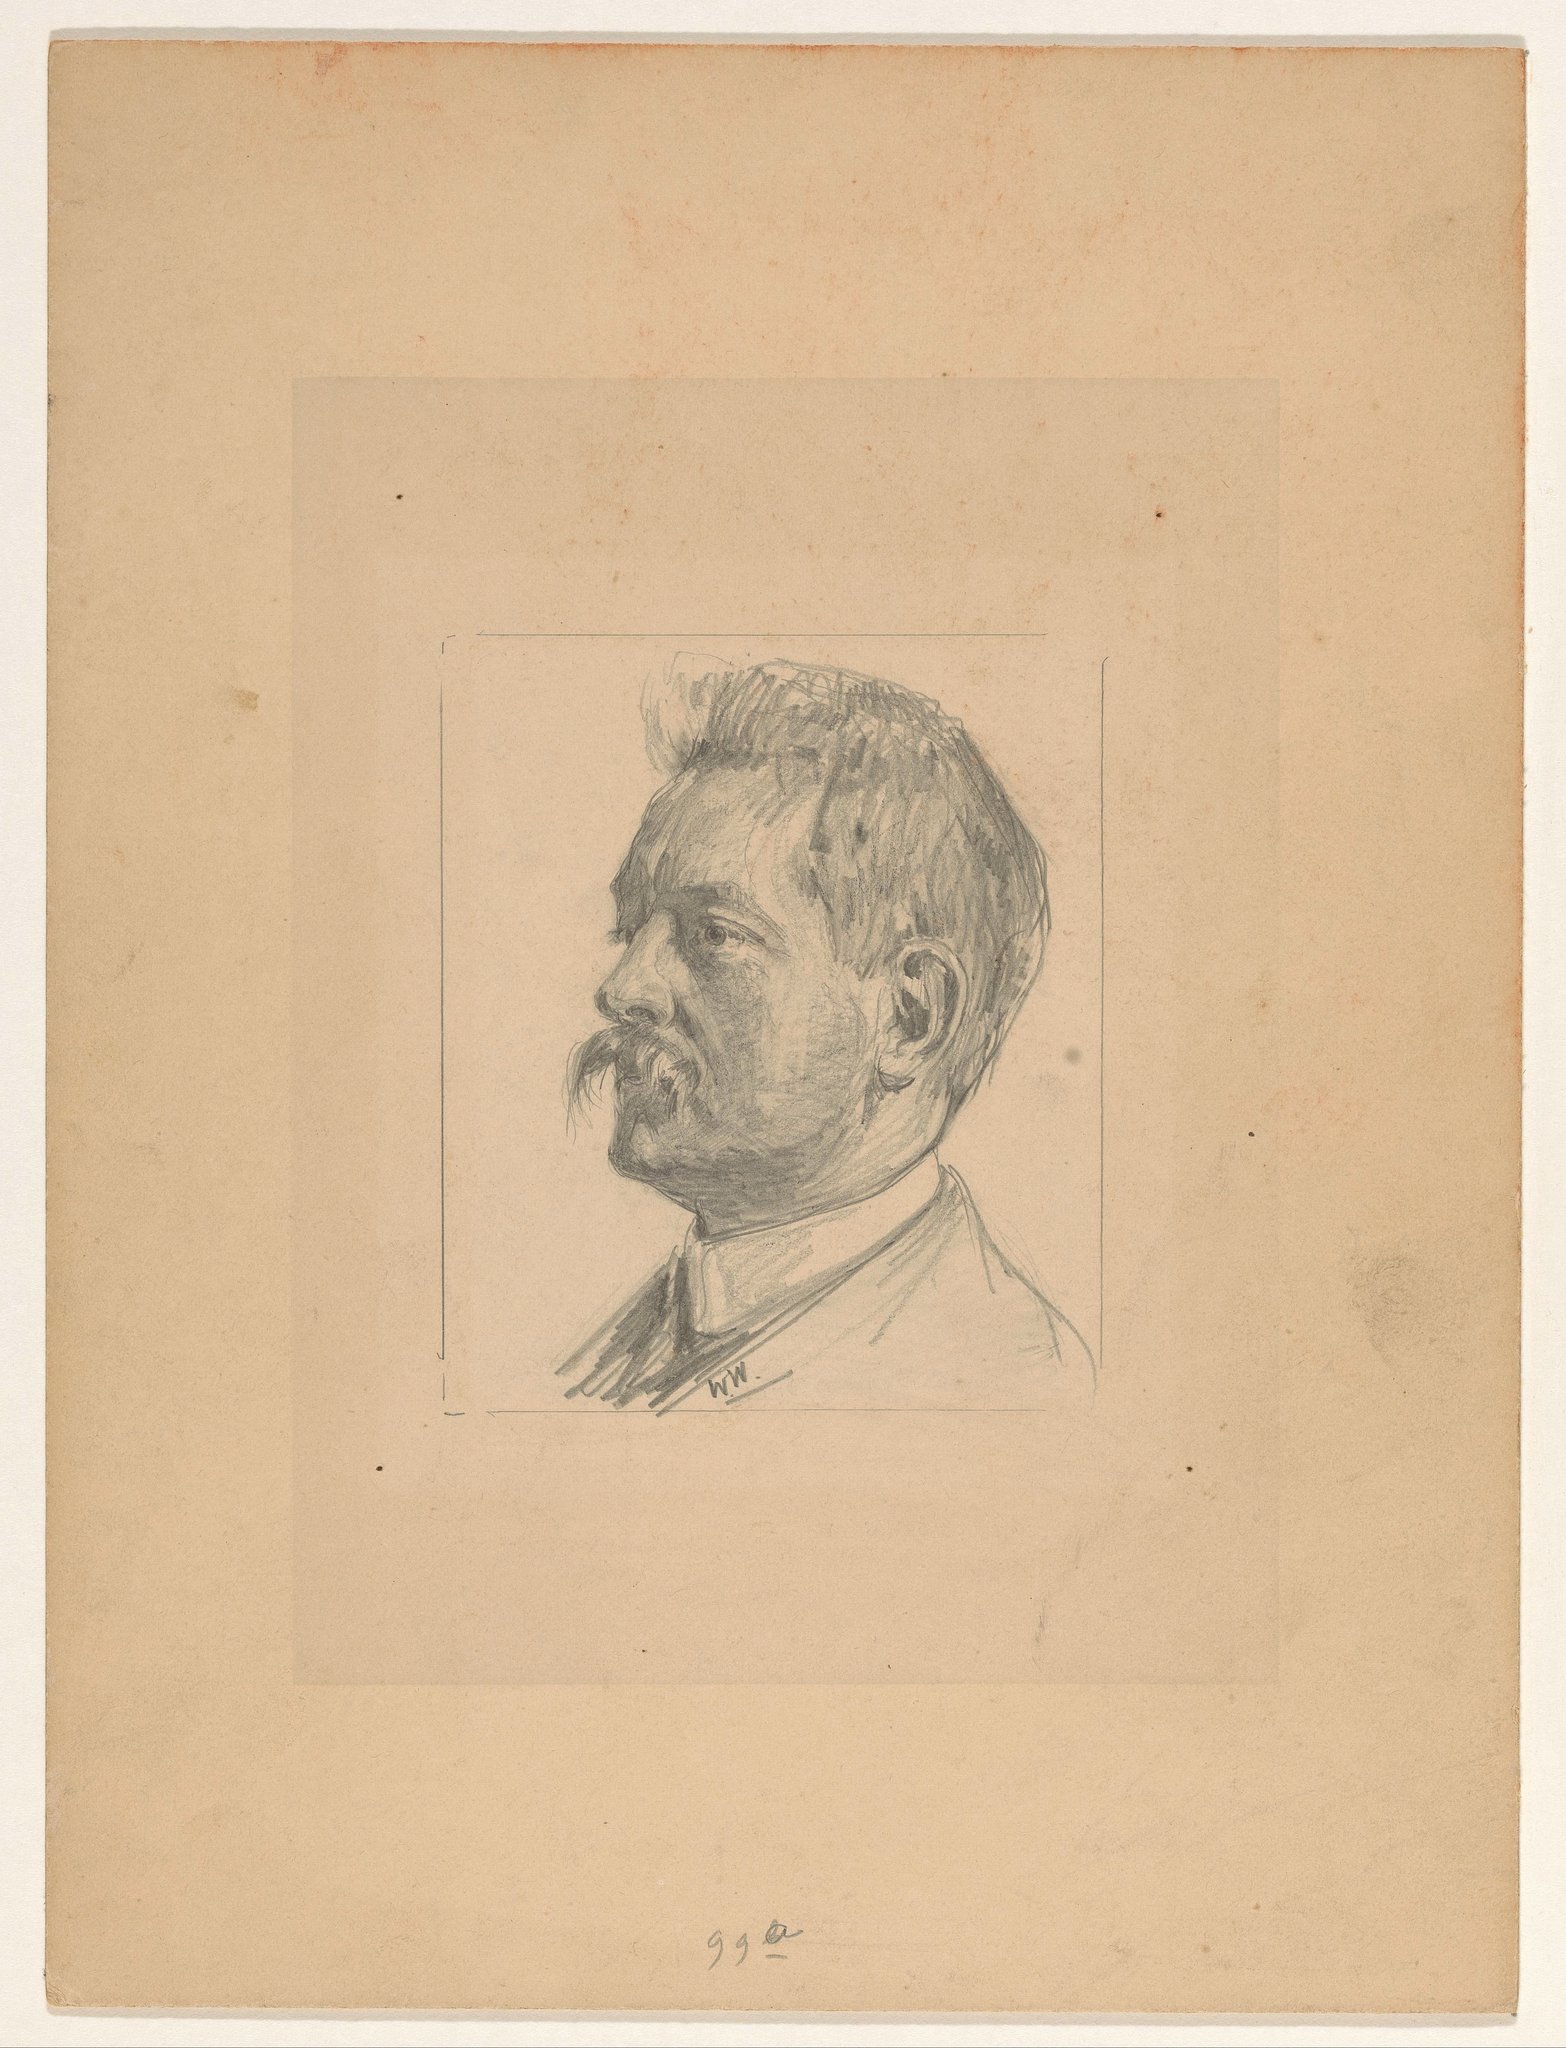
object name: drawing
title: Portret van Jan Hofker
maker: willem witsen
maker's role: draughtsman, painter, print maker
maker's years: 1860-1923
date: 1870-1923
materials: cardboard, pencil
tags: historical persons